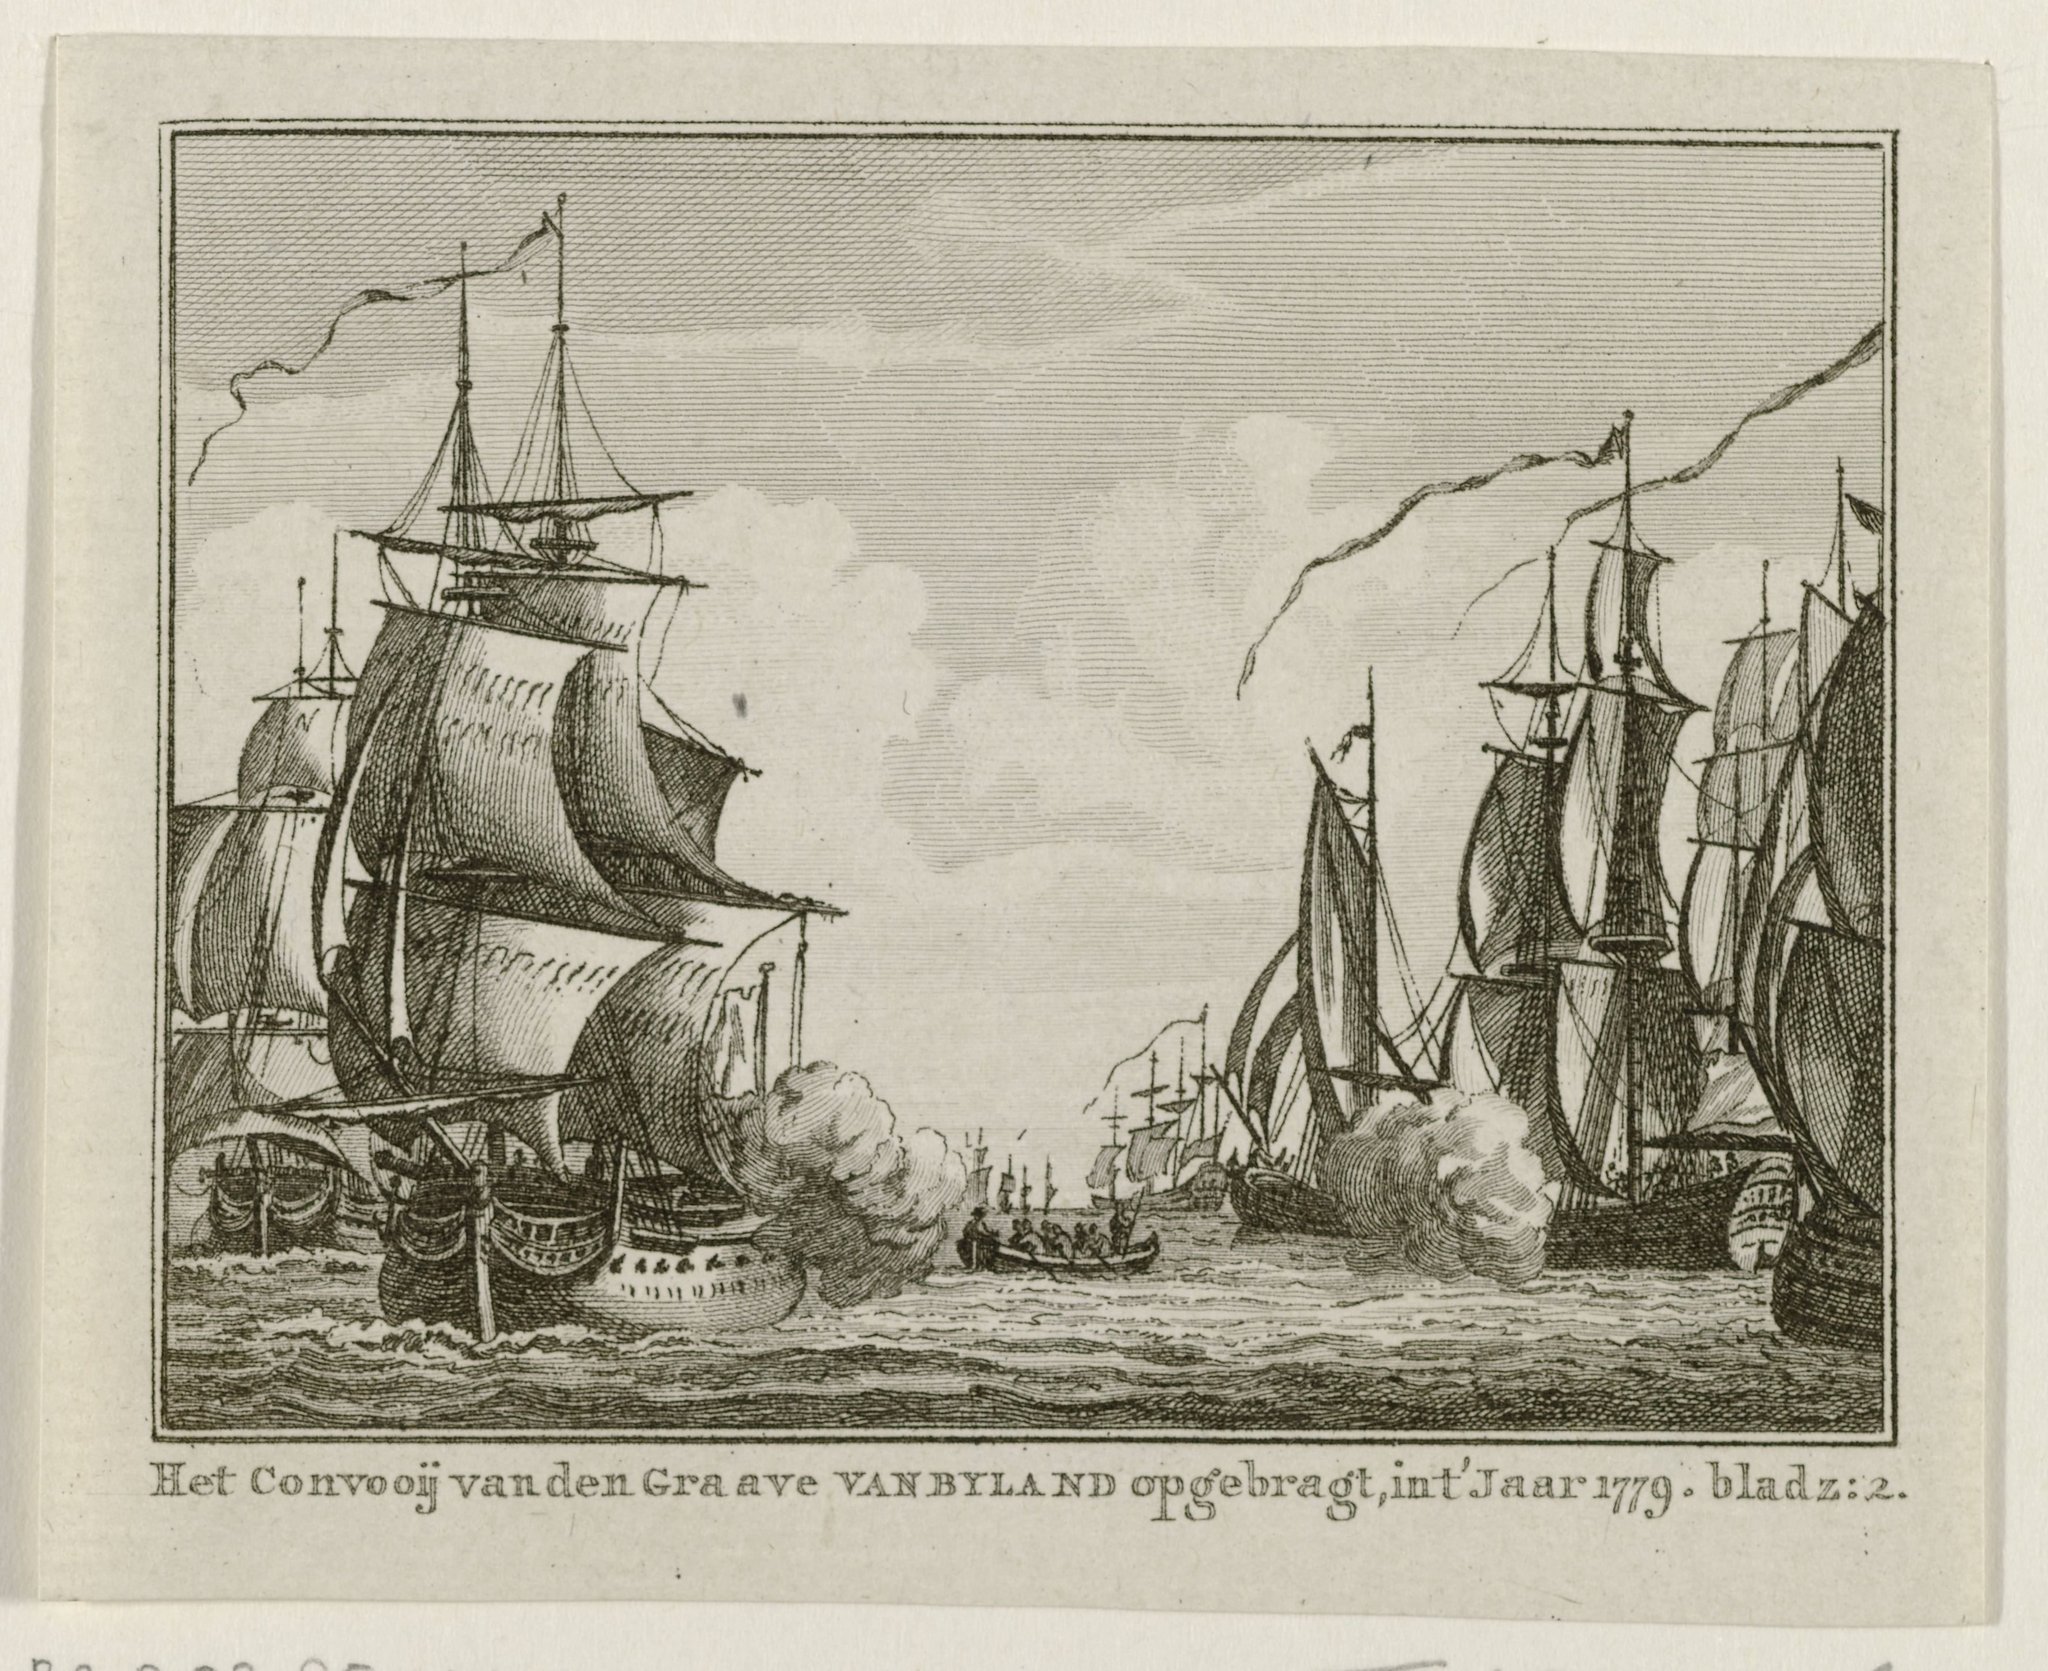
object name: history print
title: Treffen tussen Fielding en Van Bylandt, 1779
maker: simon fokke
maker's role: draughtsman, print maker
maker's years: 1712-1784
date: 1788-1790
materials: paper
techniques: engraving, etching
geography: northern netherlands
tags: battle (+ naval force)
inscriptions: collector's mark: Lugt 2228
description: Treffen tussen een Engels eskader onder bevelhebber Charles Fielding en een Nederlands eskader onder Lodewijk van Bylandt dat een konvooi begeleidde, bij Isle of Wight op 31 december 1779.